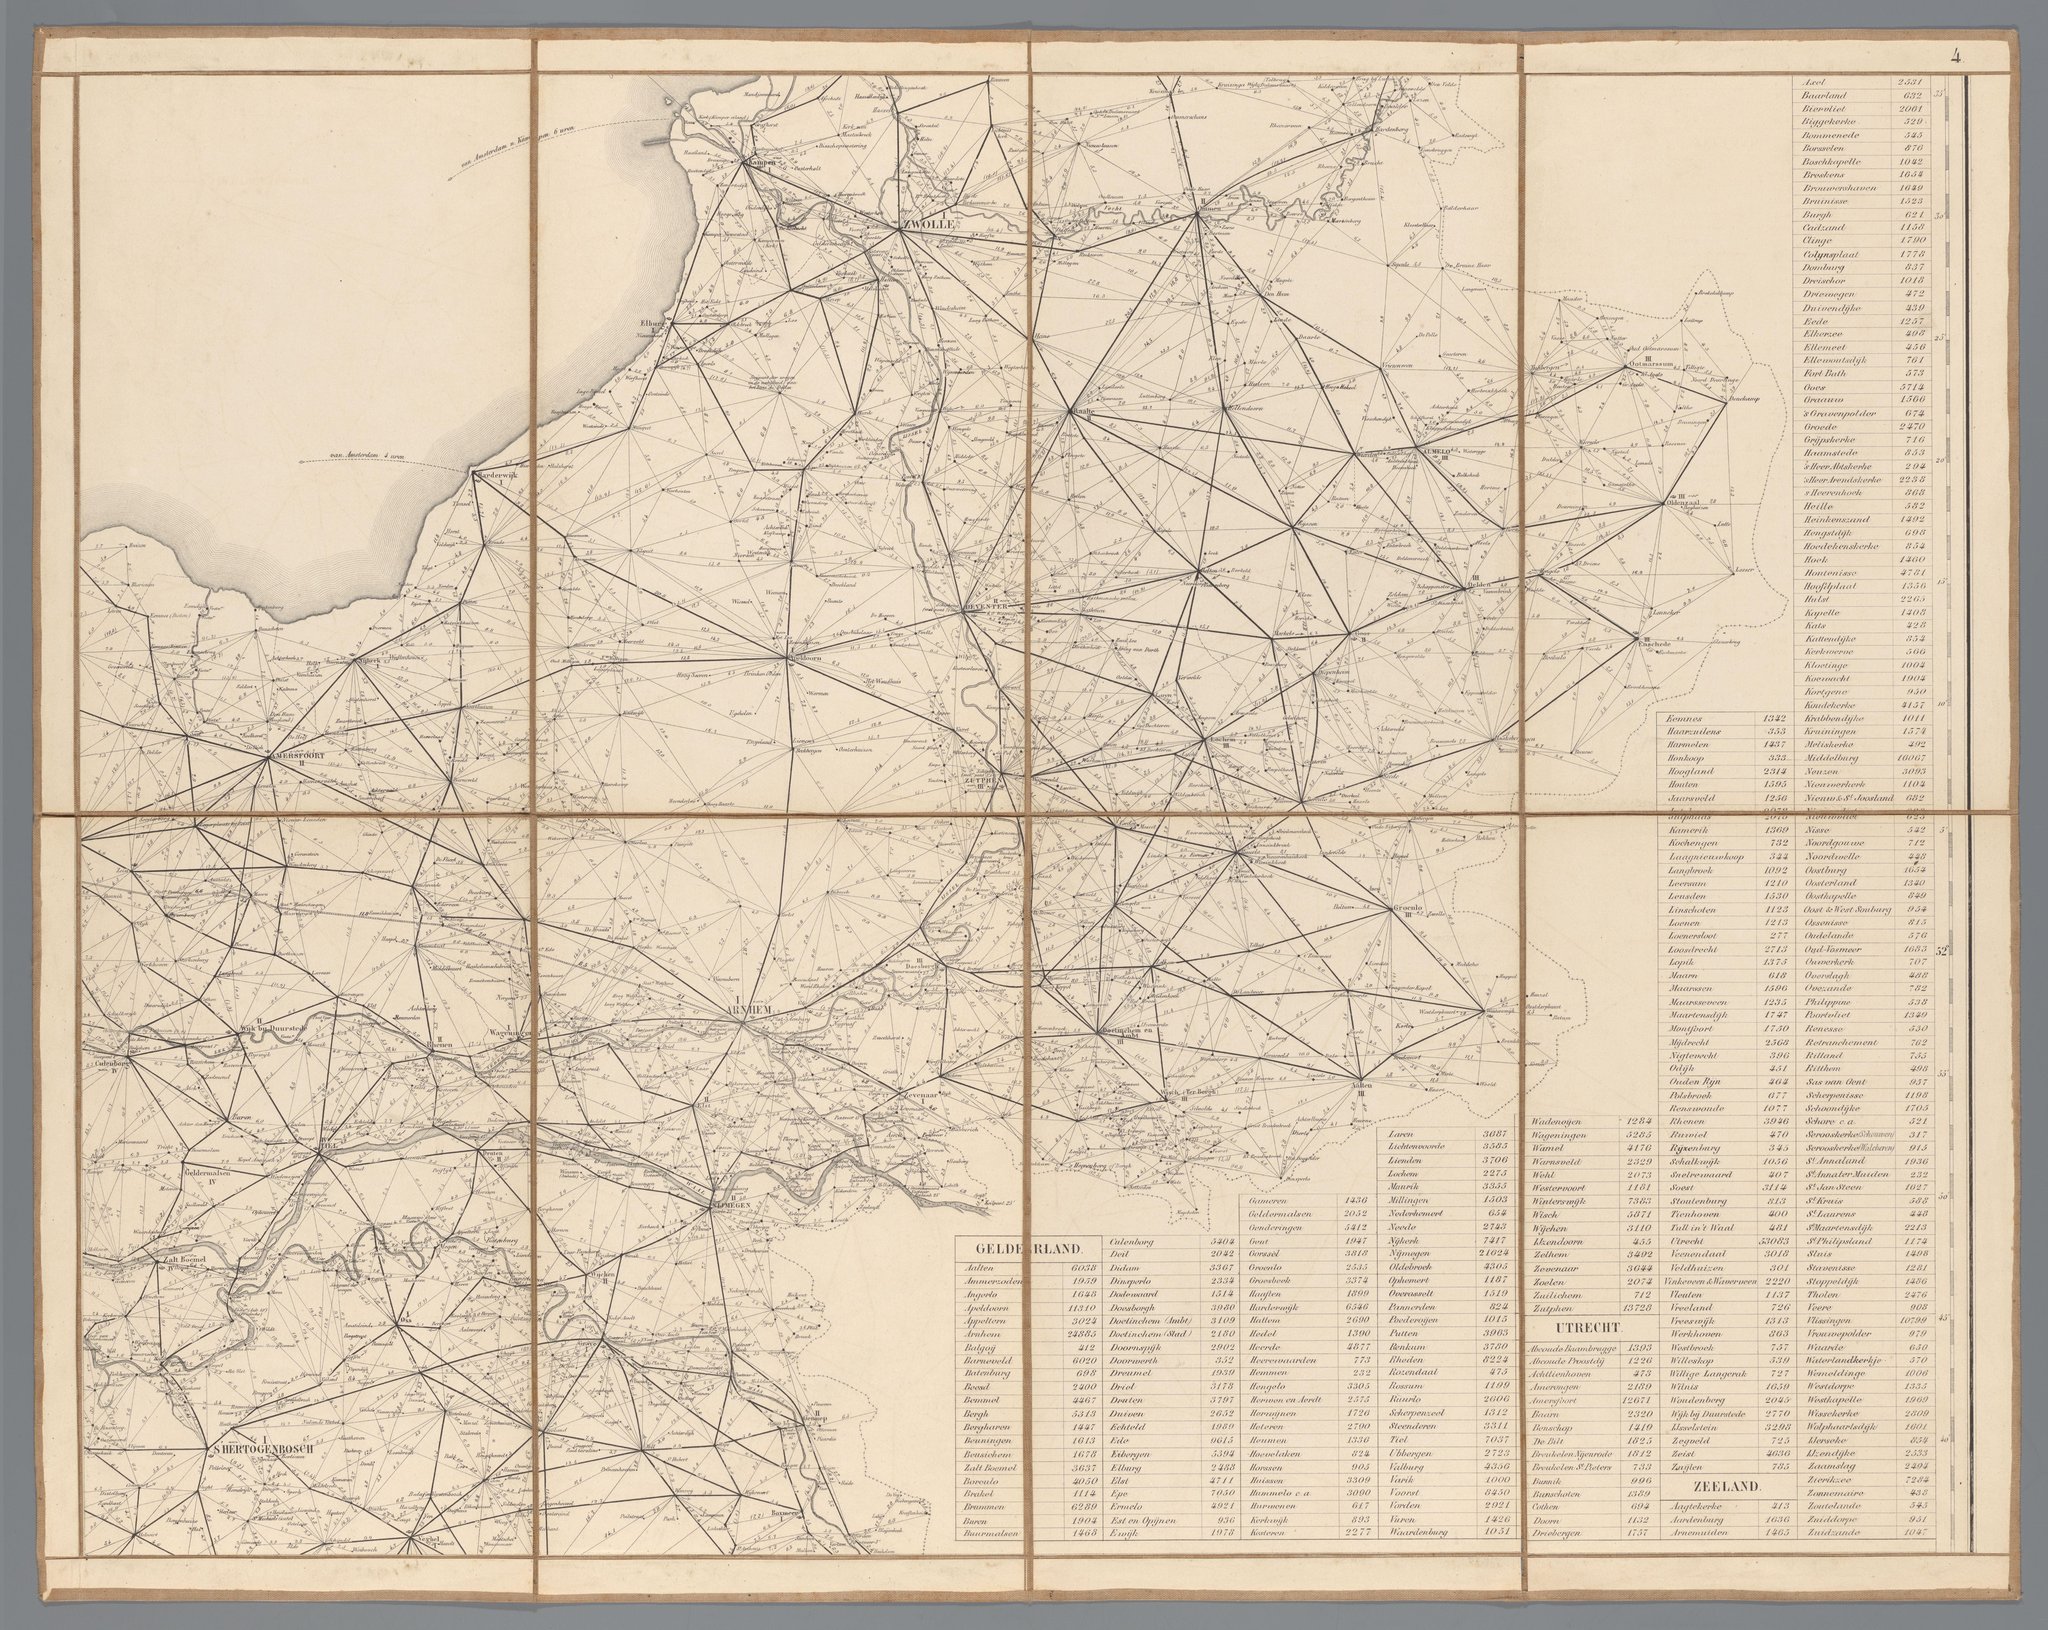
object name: map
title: Afstands-wijzer van het Koningrijk der Nederlanden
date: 1862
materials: linen, paper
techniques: lithograph, printing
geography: the hague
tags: netherlands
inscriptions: date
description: Eén van zes kaartenbladen met legenda (zie NG-934-1 t/m 6), op linnen geplakt, in kartonnen doos, buiten met zwart kunstleer beplakt en aan de binnenkant met groen-zwart ruitjespapier. Gedateerd; blad 3, l.b.: 1862.